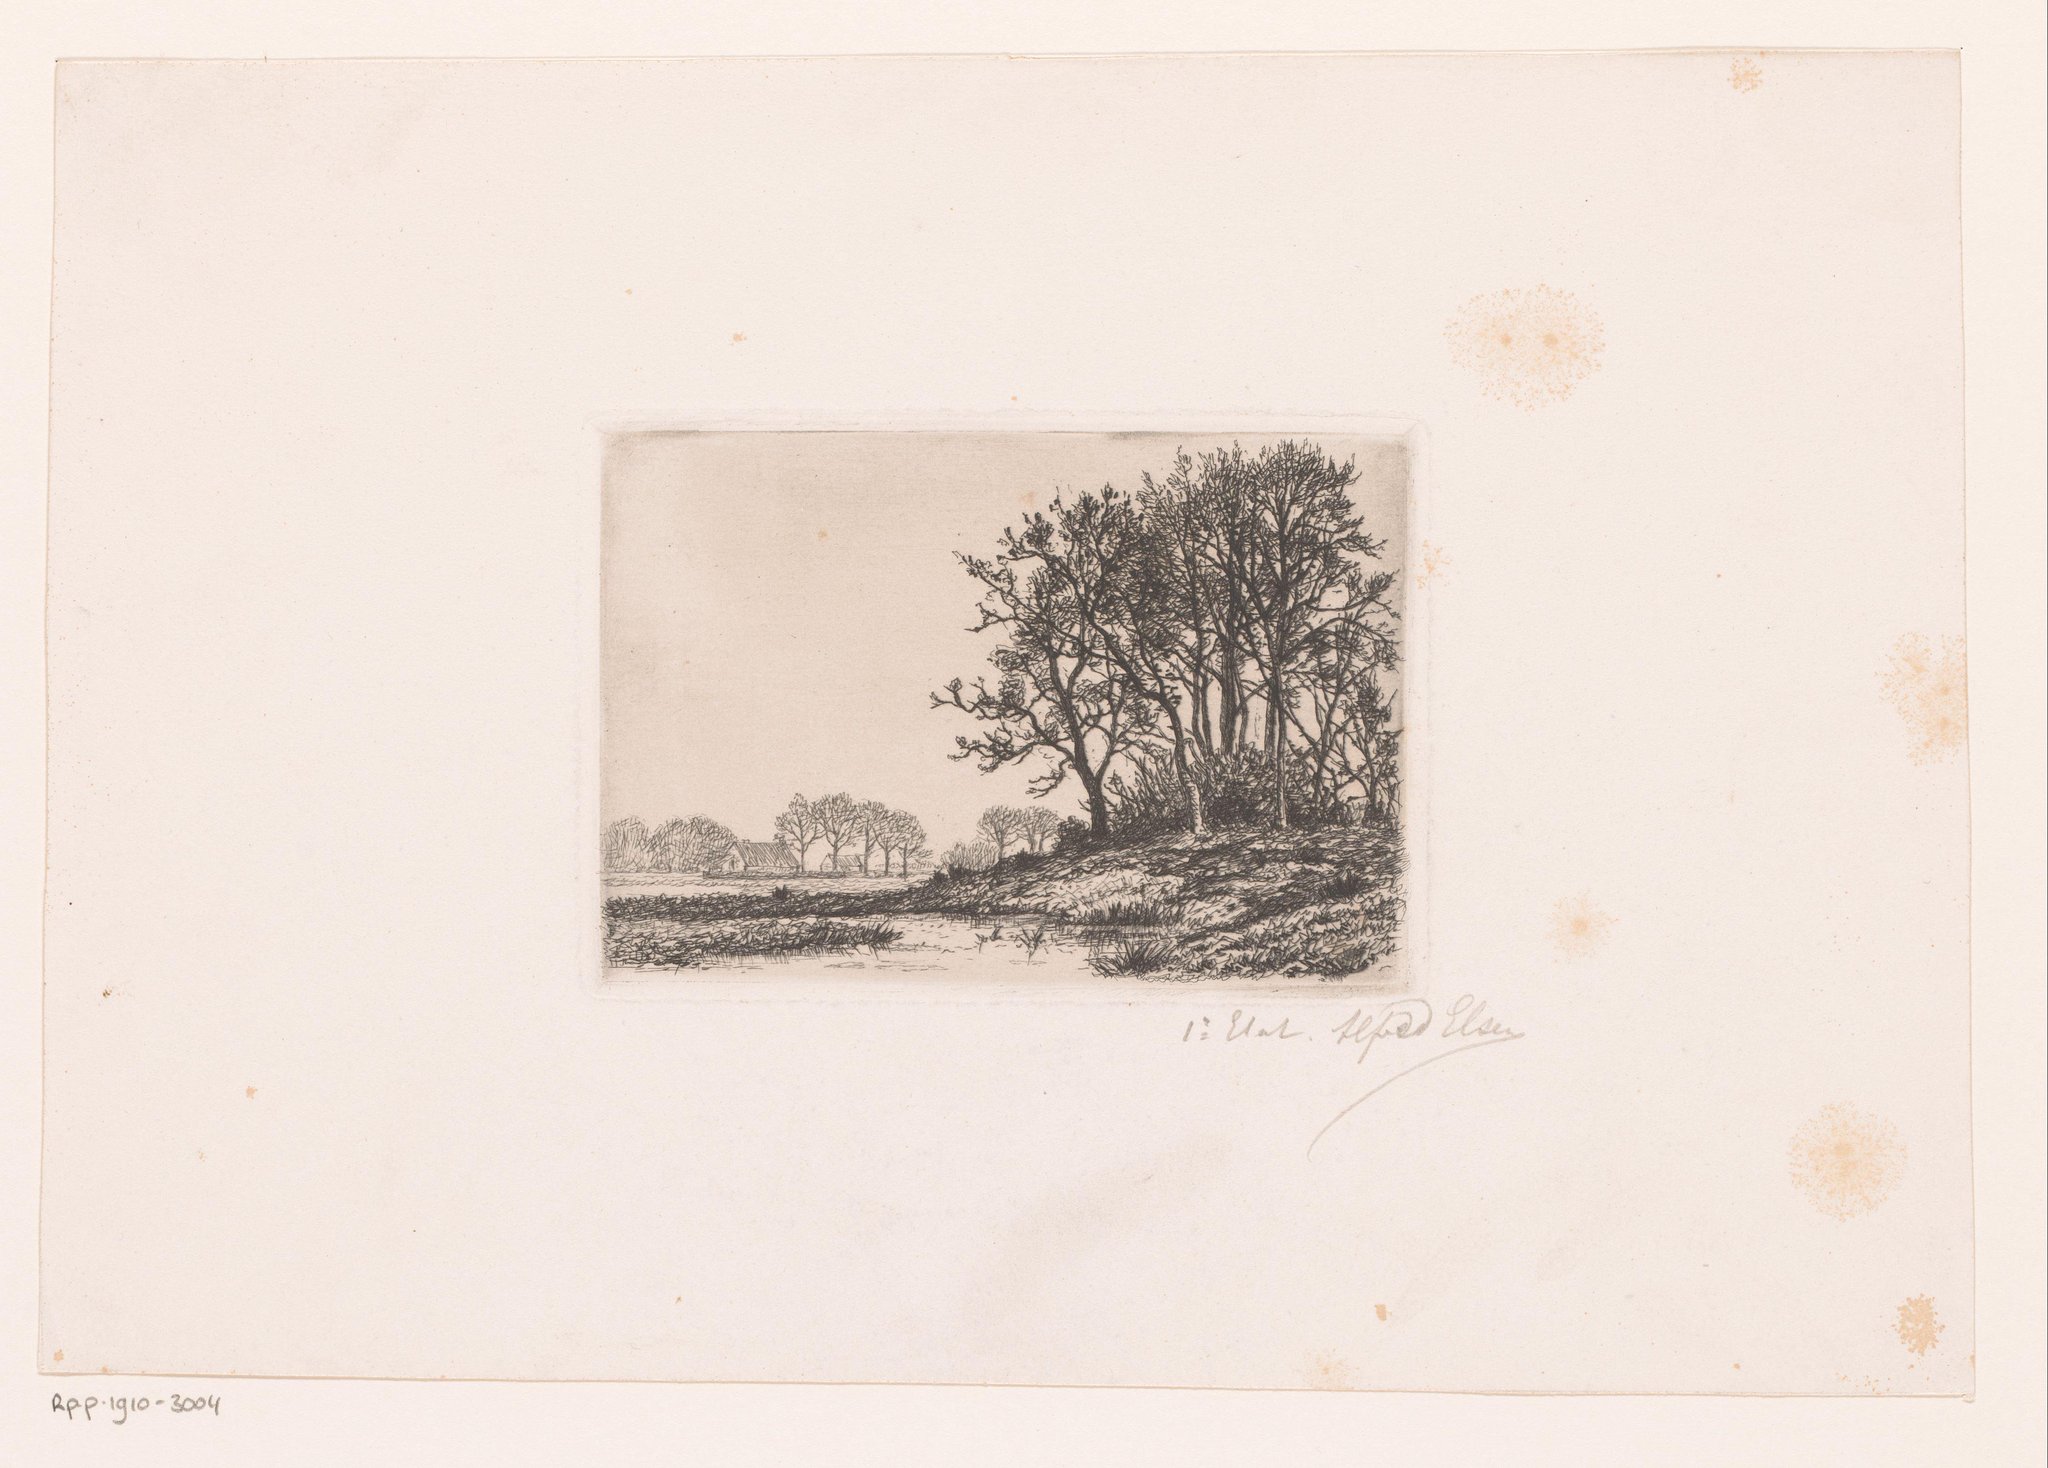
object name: print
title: Landschap met bomen op een heuvel aan het water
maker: alfred elsen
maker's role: painter, print maker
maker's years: 1850-1914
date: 1860-1910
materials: paper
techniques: etching, intaglio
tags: low hill country, landscapes with waters, waterscapes, seascapes (in the temperate zone), farm or solitary house in landscape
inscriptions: inscription: ‘1e Etat’, collector's mark: Lugt 2228